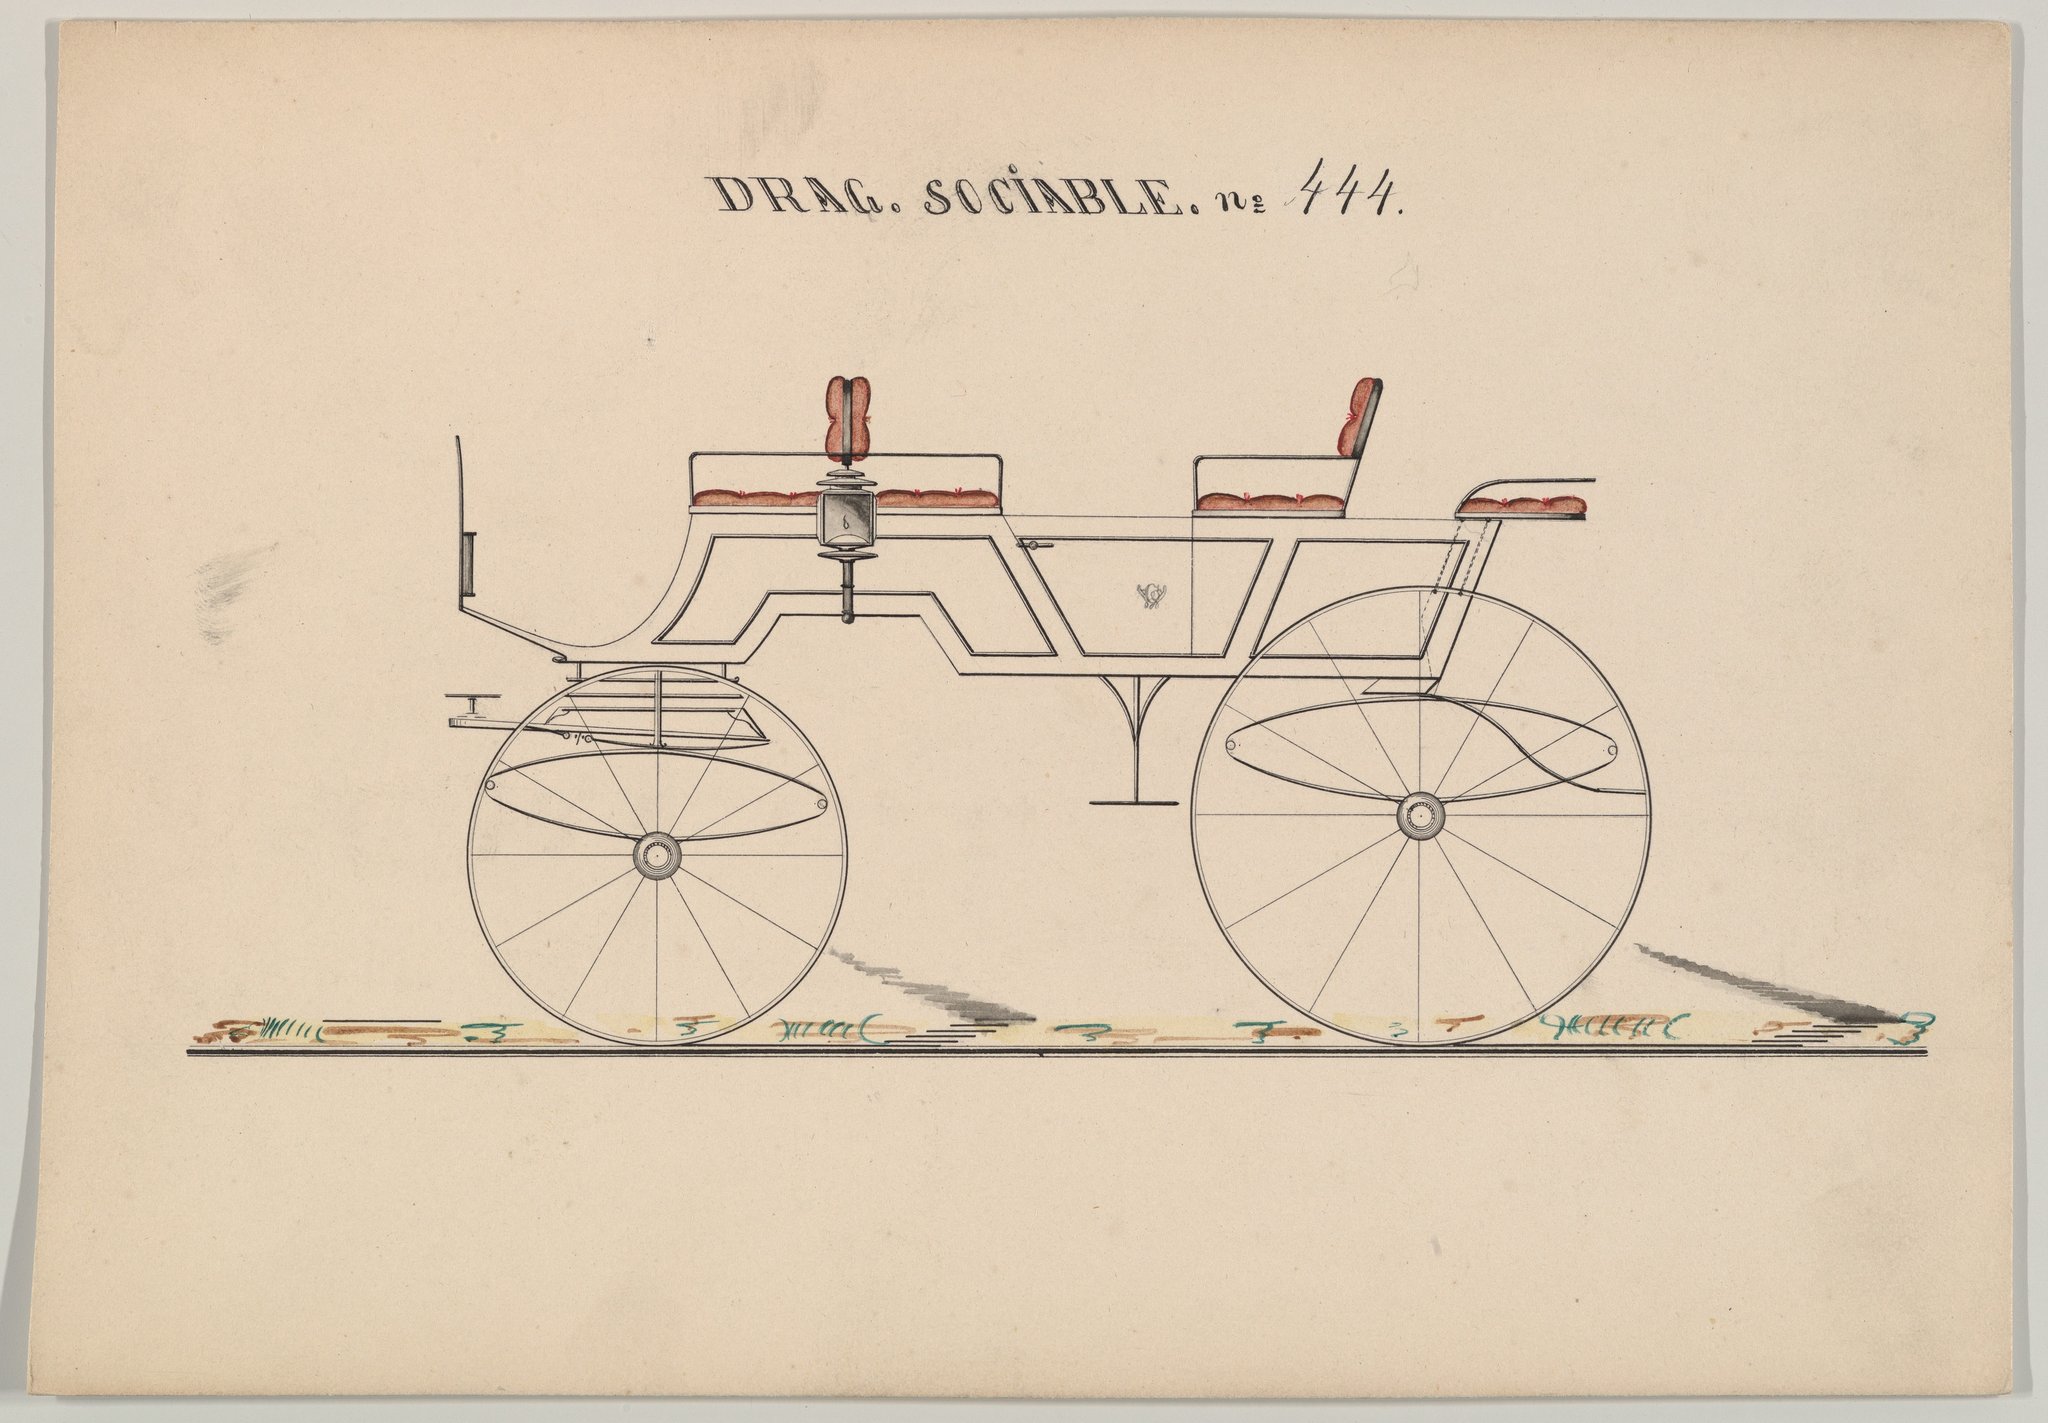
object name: drawing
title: Drag/Socialble # 444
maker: brewster & co.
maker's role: manufacturer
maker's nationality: american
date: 1850-1870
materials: ink, watercolor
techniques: pen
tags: carriages